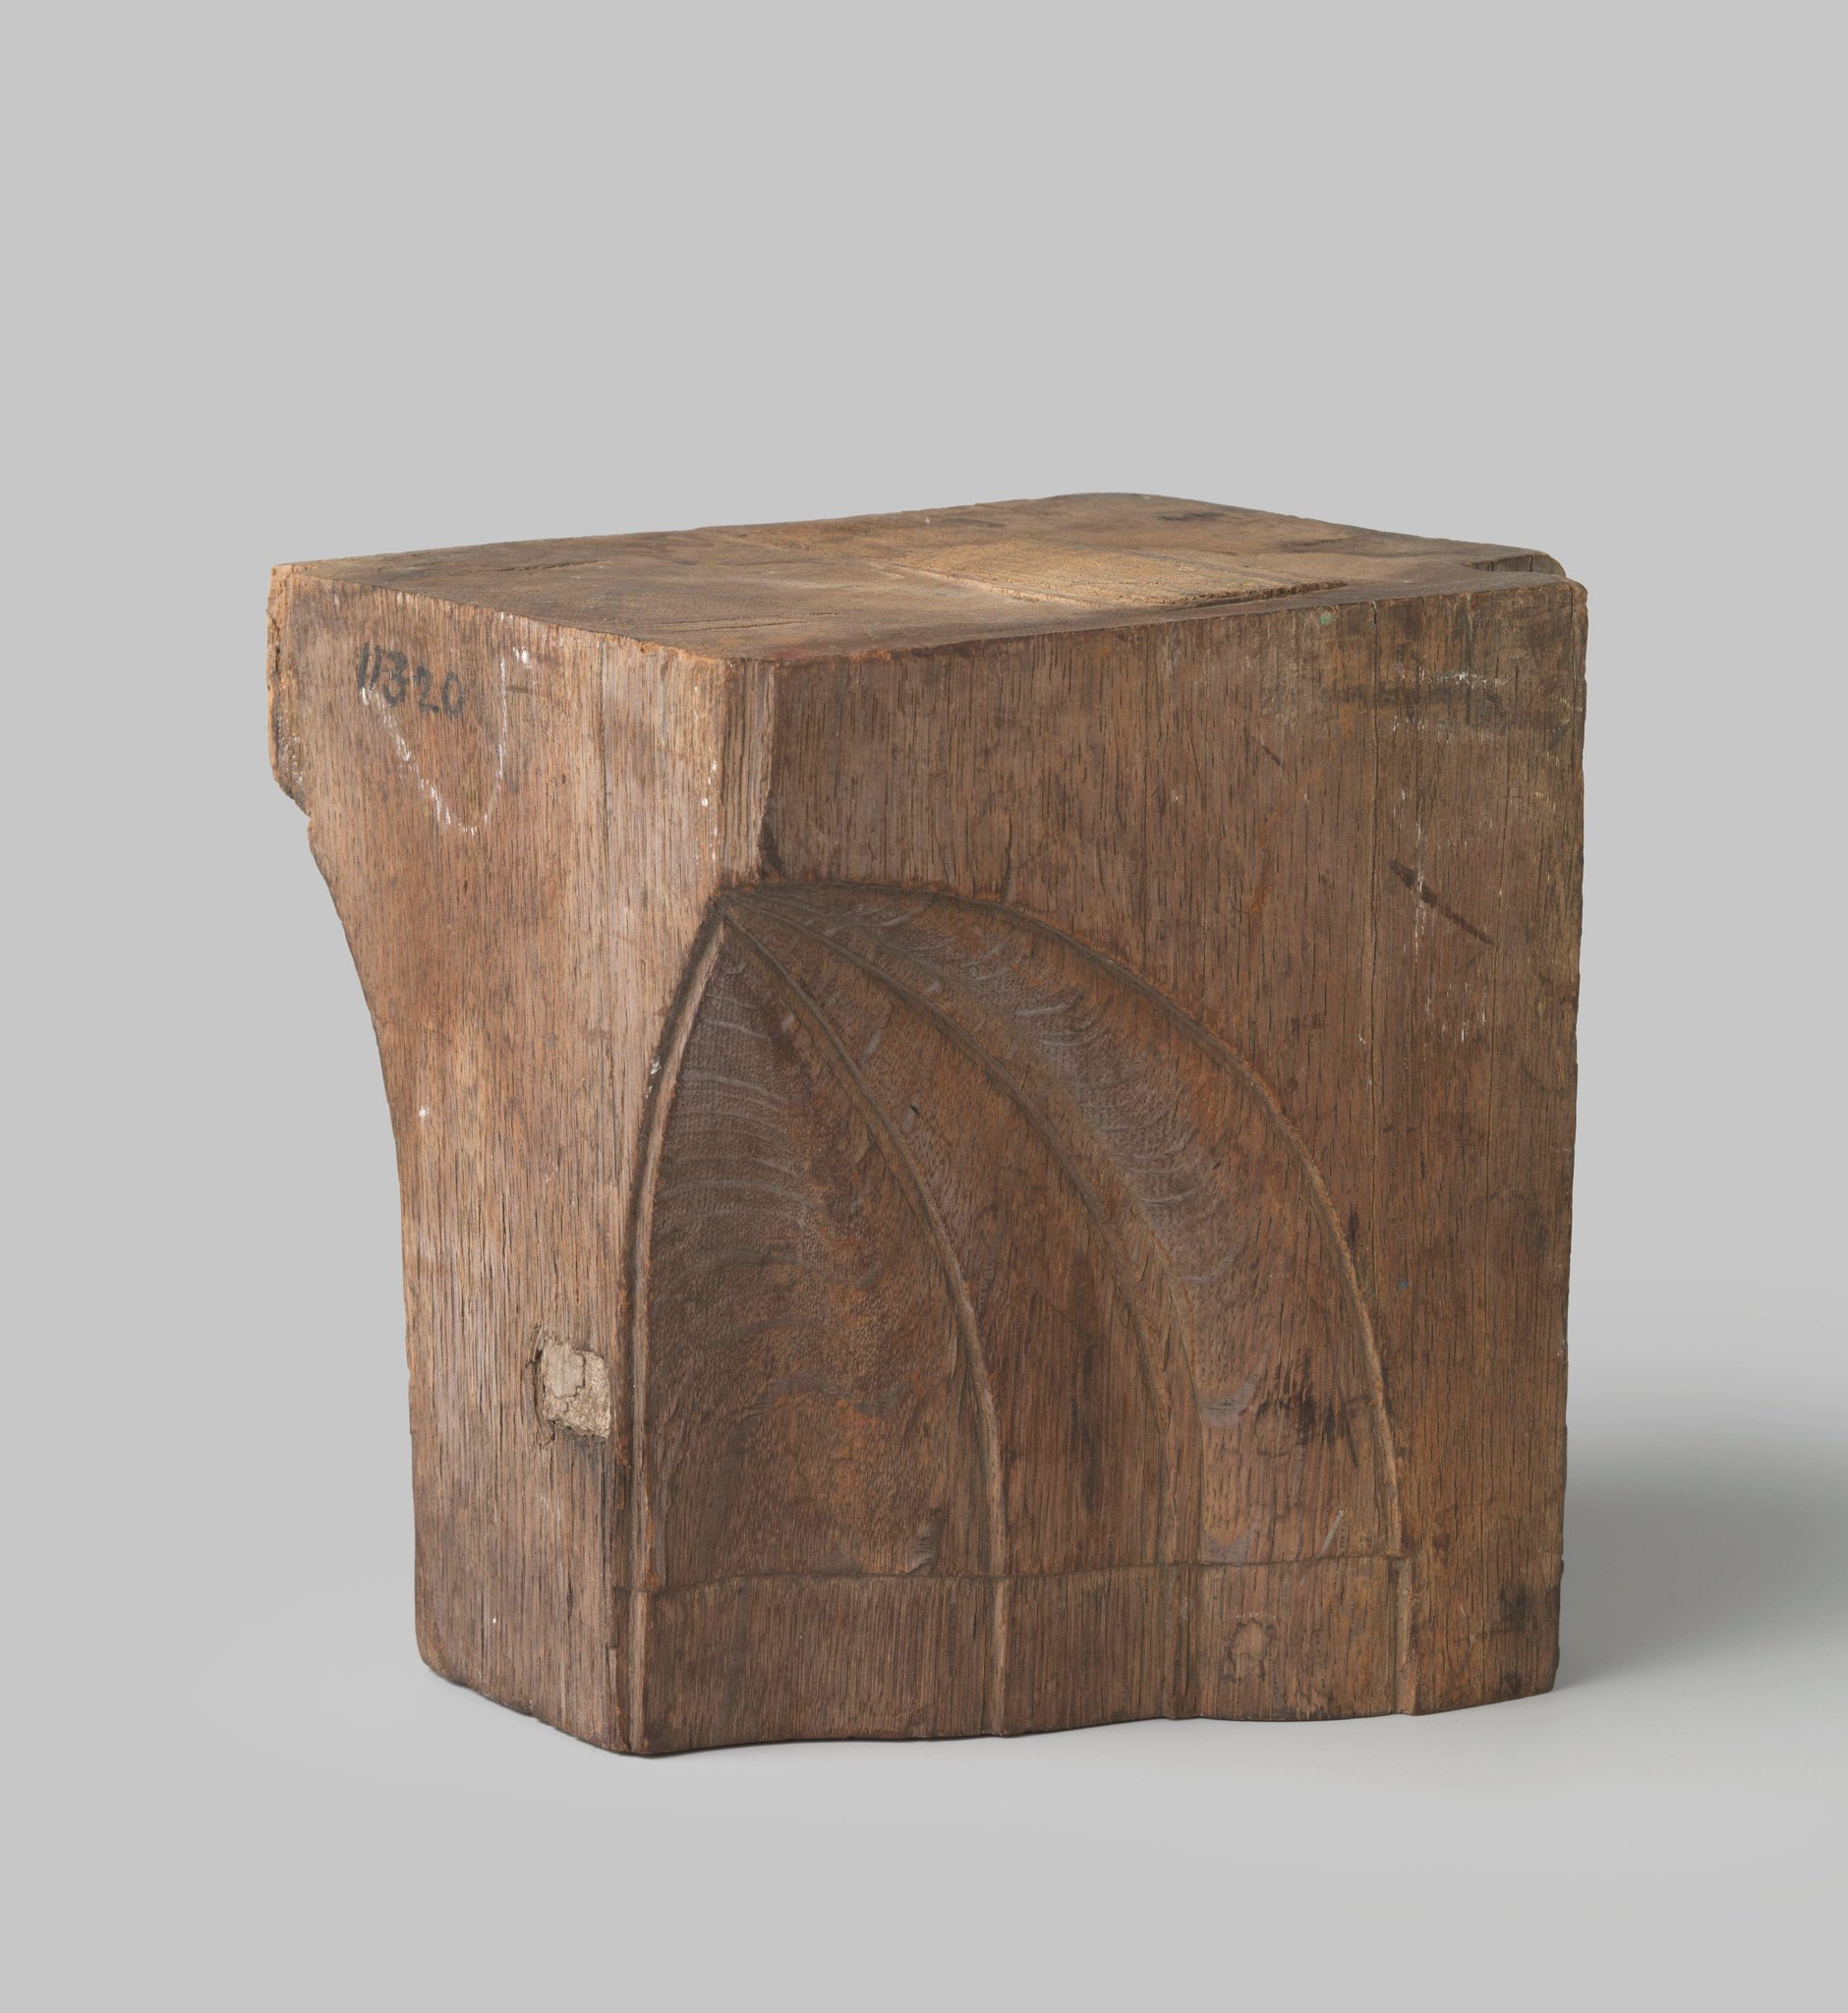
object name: architectural element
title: Bouwfragment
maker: Anonymous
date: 1500-1600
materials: wood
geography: netherlands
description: Fragment van een eikenhouten balk met een laat-Gotisch profiel.